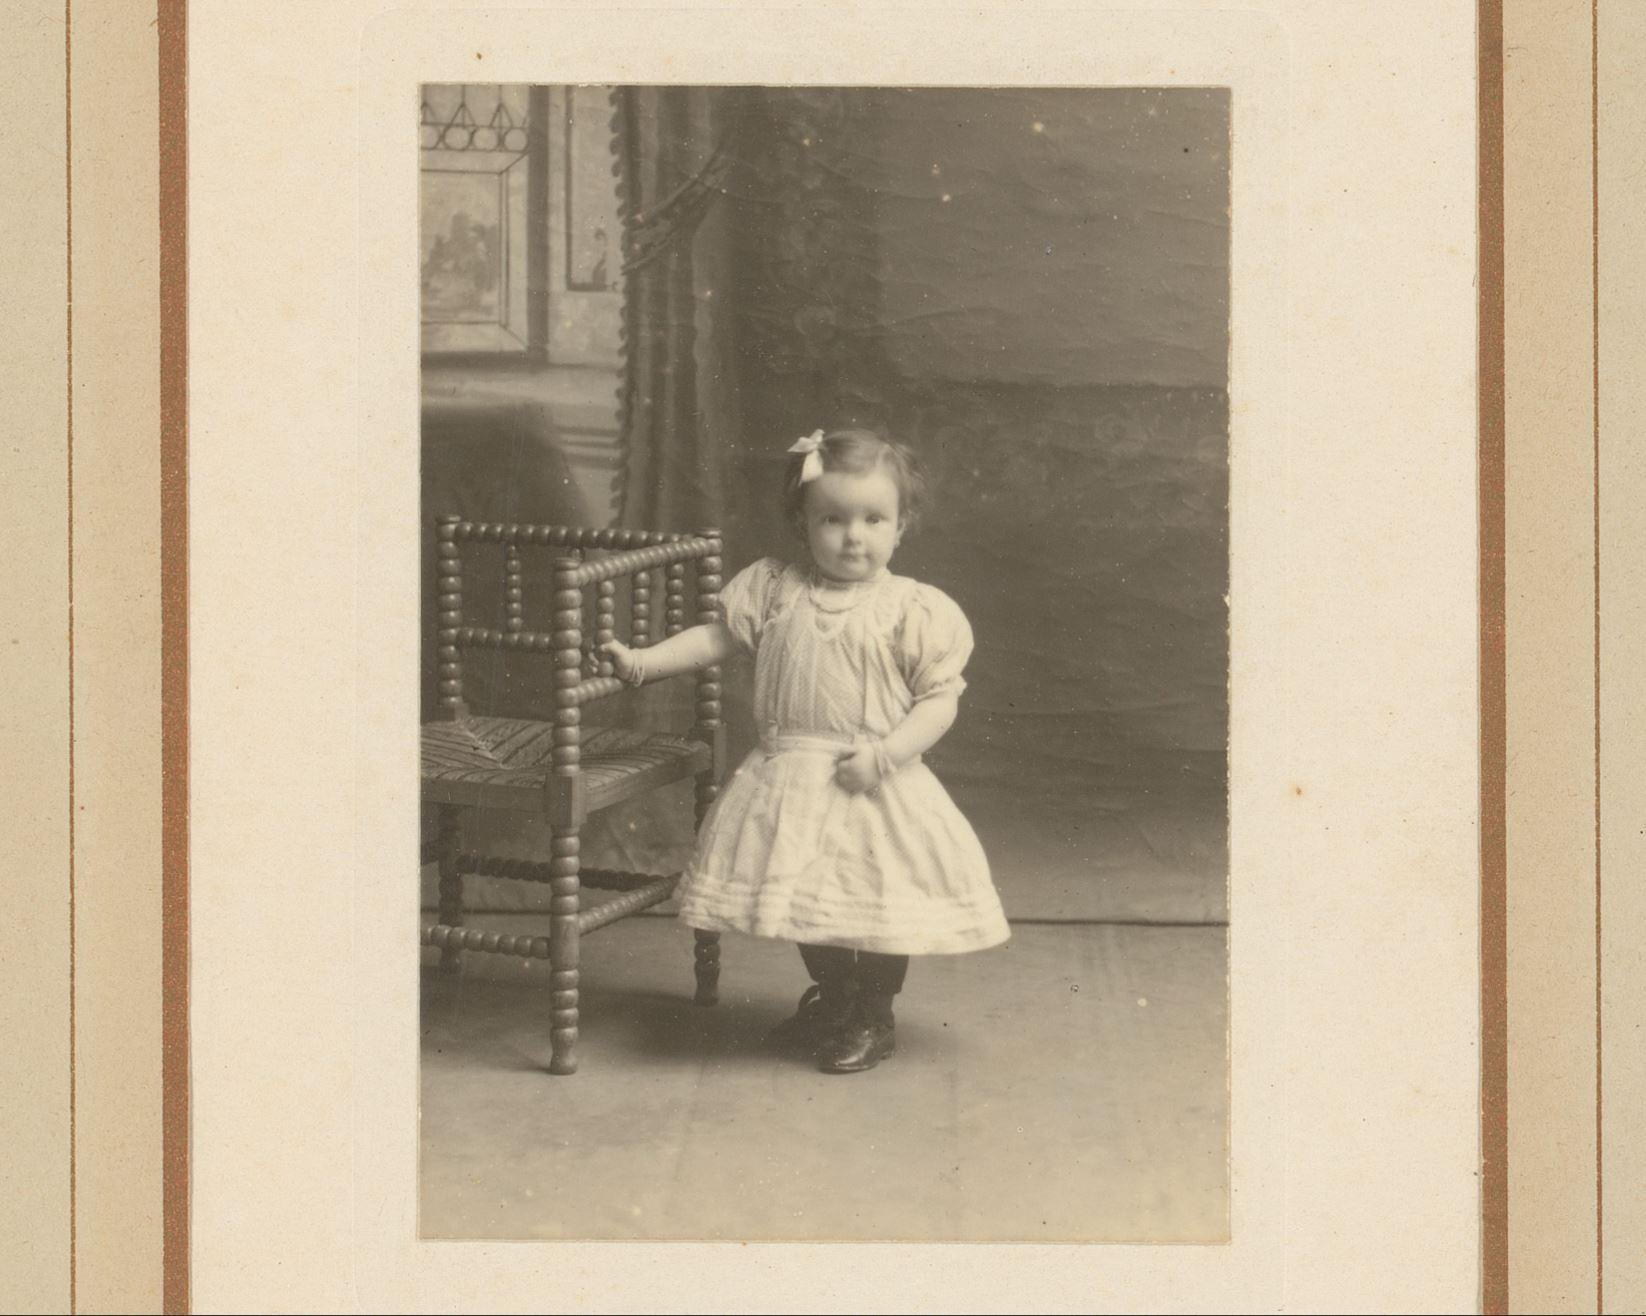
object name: cabinet photograph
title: Portret van een staand meisje bij een stoel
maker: dirk van der list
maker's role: fotograaf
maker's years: 1883-1945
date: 1900-1924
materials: cardboard, photographic support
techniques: gelatin silver print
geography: haarlem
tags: girl (child between toddler and youth)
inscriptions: inscription: ‘D. van der Llist/ Gasthuissingel 54 Haarlem’